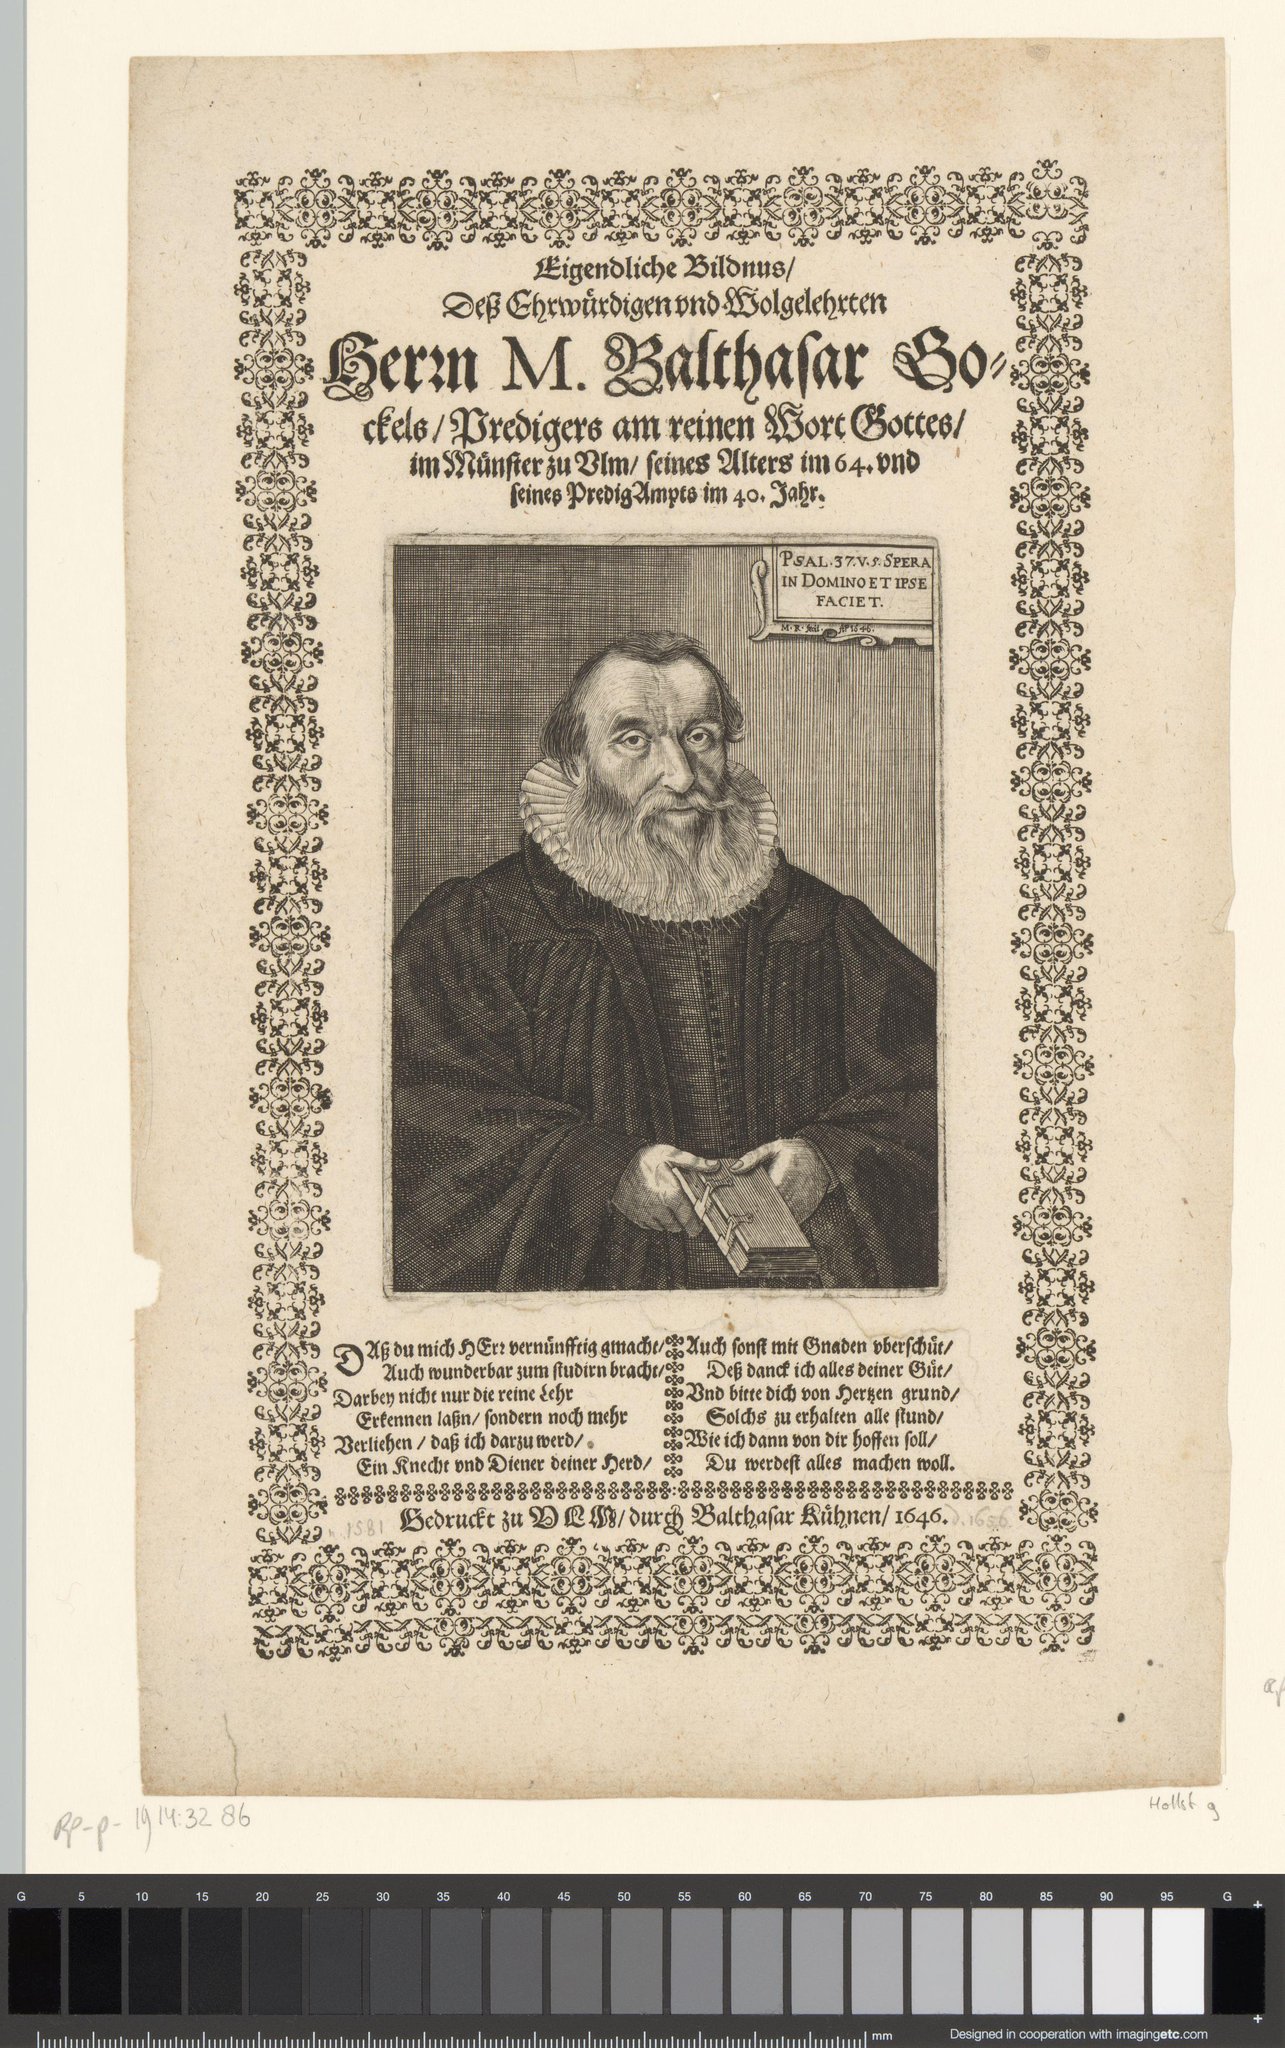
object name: print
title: Portret van Balthasar Gockel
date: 1646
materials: paper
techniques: engraving, letterpress printing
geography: ulm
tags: historical persons, book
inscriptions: collector's mark: Lugt 2228, date